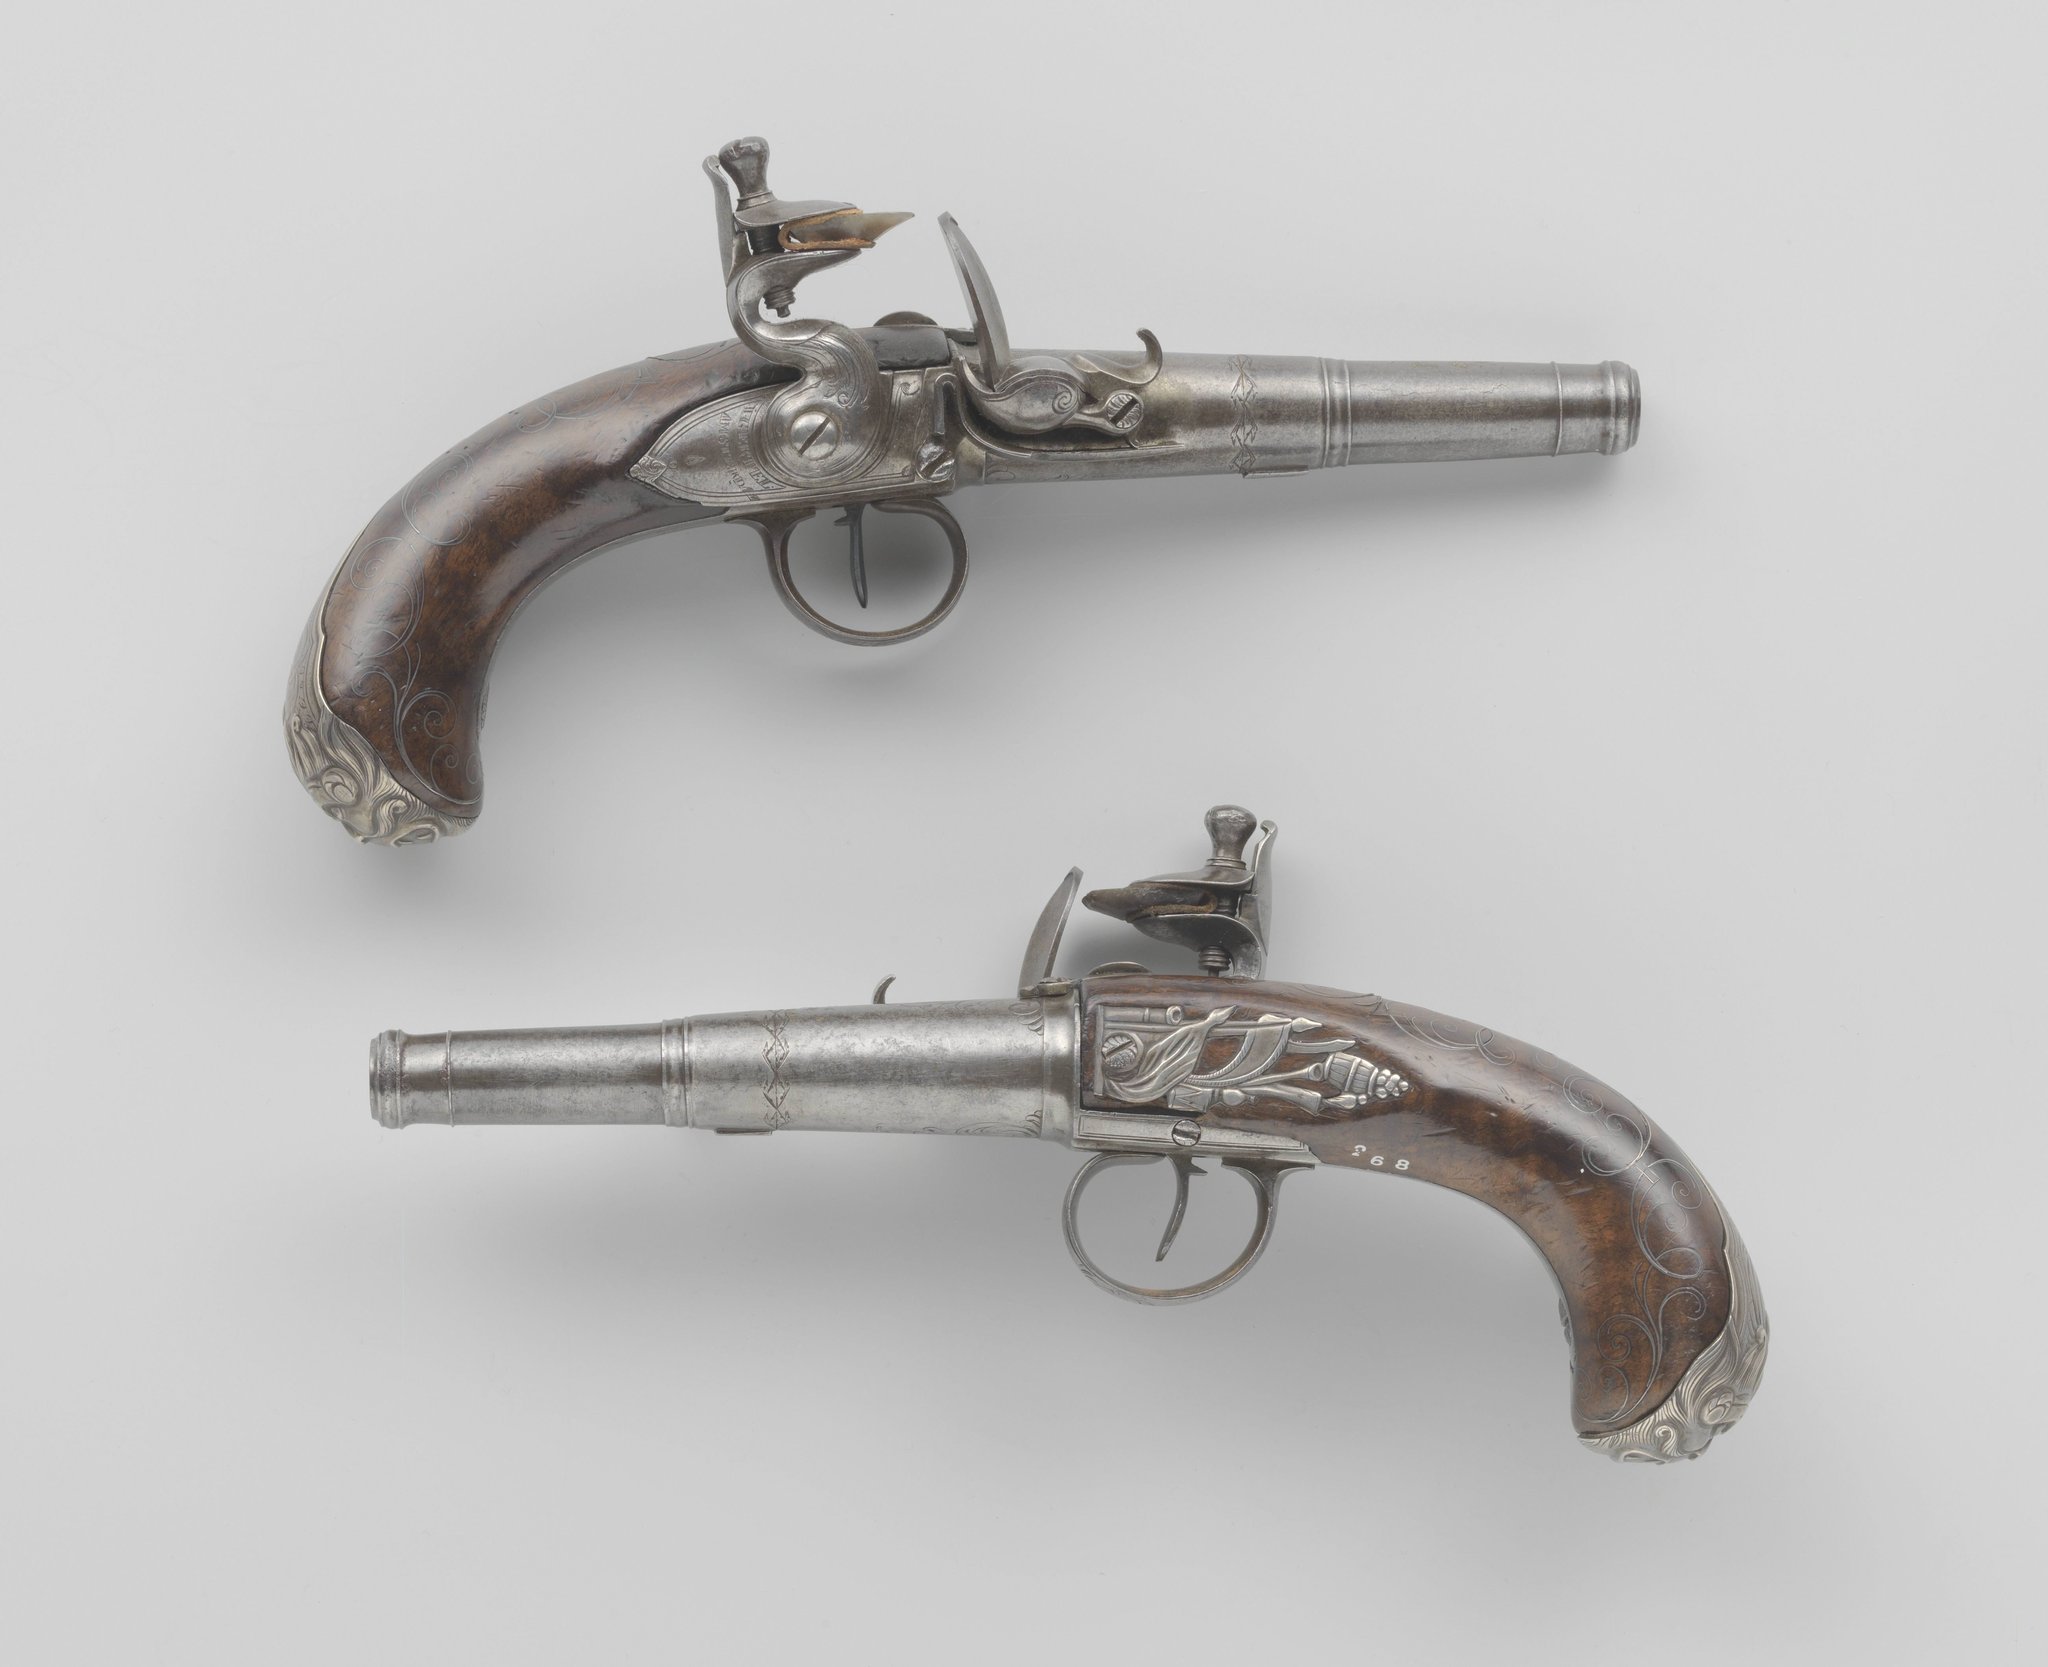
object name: pocket pistol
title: Vuursteenzakpistool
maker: johan george ertel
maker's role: geweermaker, pistoolmaker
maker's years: 1728-1795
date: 1765-1775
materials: iron, silver, thread, wood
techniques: casting, metalworking, embroidery, encrustation, engraving, relief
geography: amsterdam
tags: netherlands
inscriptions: signature: ‘I.G.ERTEL // AMSTERDAM’